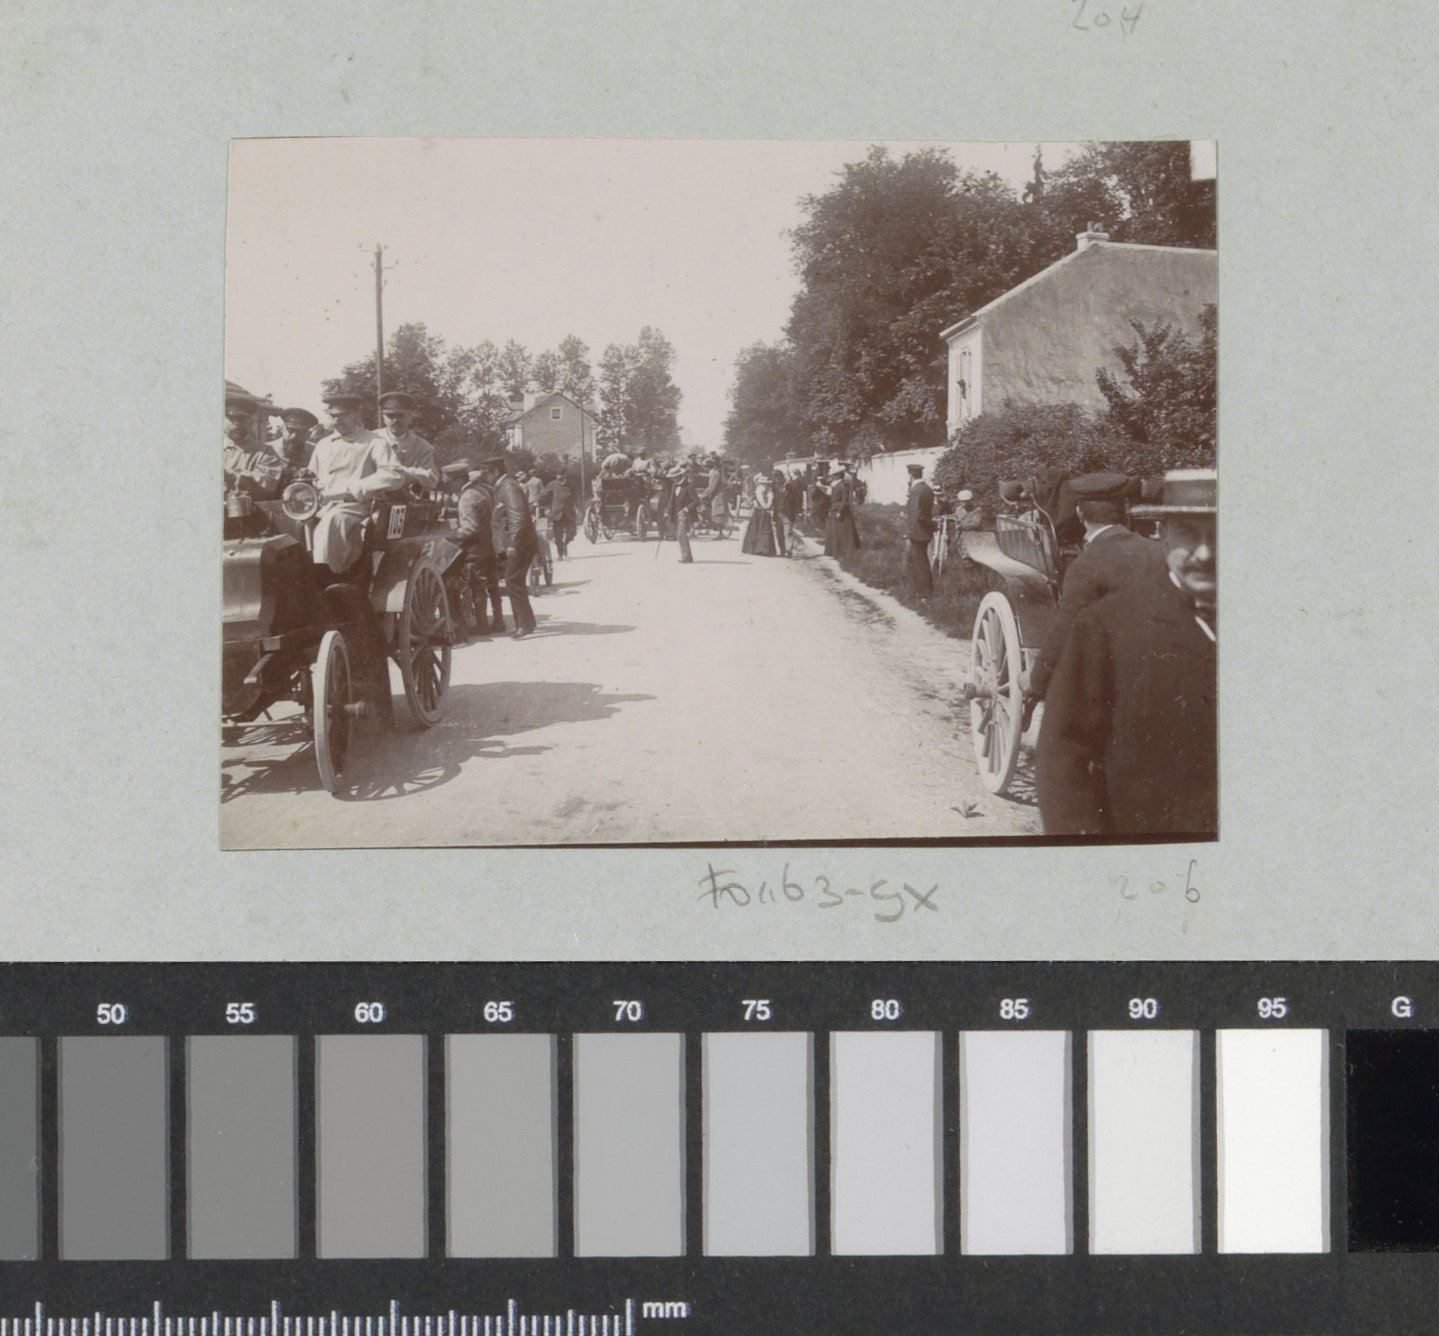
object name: photograph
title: Start van de race Parijs-Amsterdam voor automobielen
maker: delizy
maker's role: manufacturer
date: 1898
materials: paper, photographic support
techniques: gelatin silver print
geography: paris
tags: motorcar racing, automobile, street (+ city(-scape) with figures, staffage), paris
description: Onderdeel van Fotoalbum van een Franse amateurfotograaf met opnames van uitstapjes in Frankrijk, Spanje, België, Luxemburg en Nederland, de eerste automobielen en autoraces.